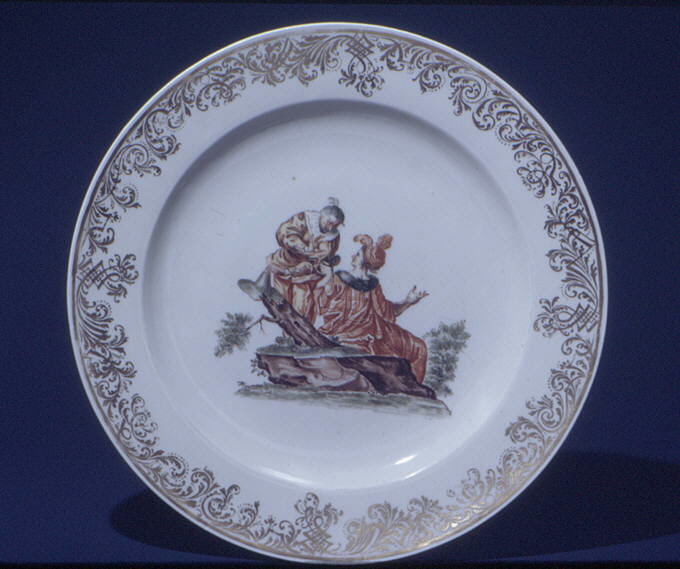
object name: plate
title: Plate (one of two)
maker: meissen manufactory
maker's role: manufactory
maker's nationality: german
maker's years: 1710-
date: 1760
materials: hard paste porcelain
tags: men,women